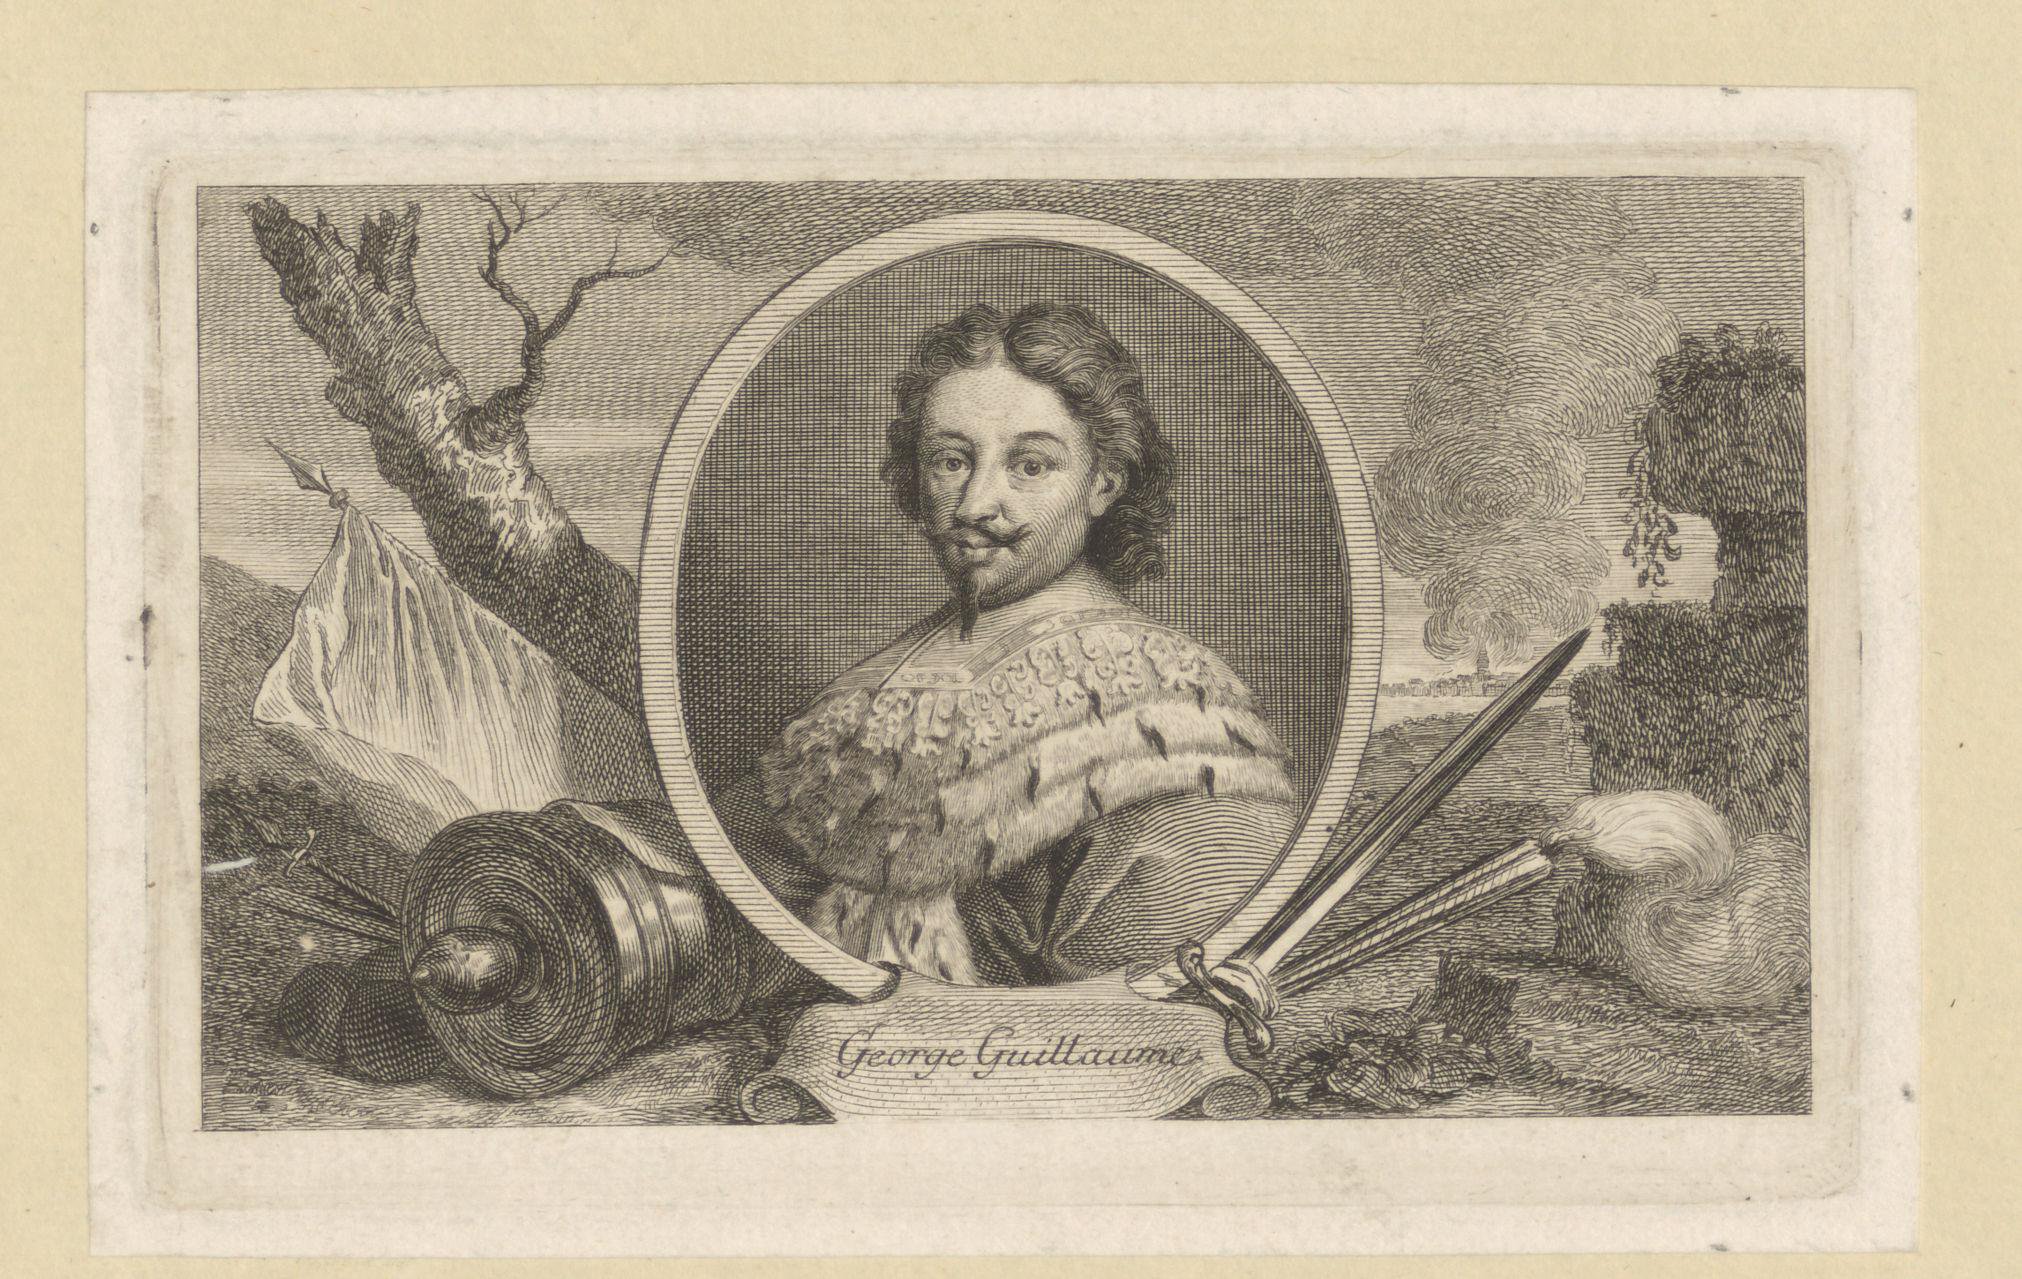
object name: book illustration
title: Portret van Georg Wilhelm van Brandenburg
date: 1751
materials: paper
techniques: engraving, etching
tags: cologne, historical persons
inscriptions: collector's mark: Lugt 240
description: Prent ook gebruikt in: Frederik de Grote. Mémoires pour servir a l'histoire de la maison de Brandebourg. Sanssouci, Frederik de Grote, 1751.